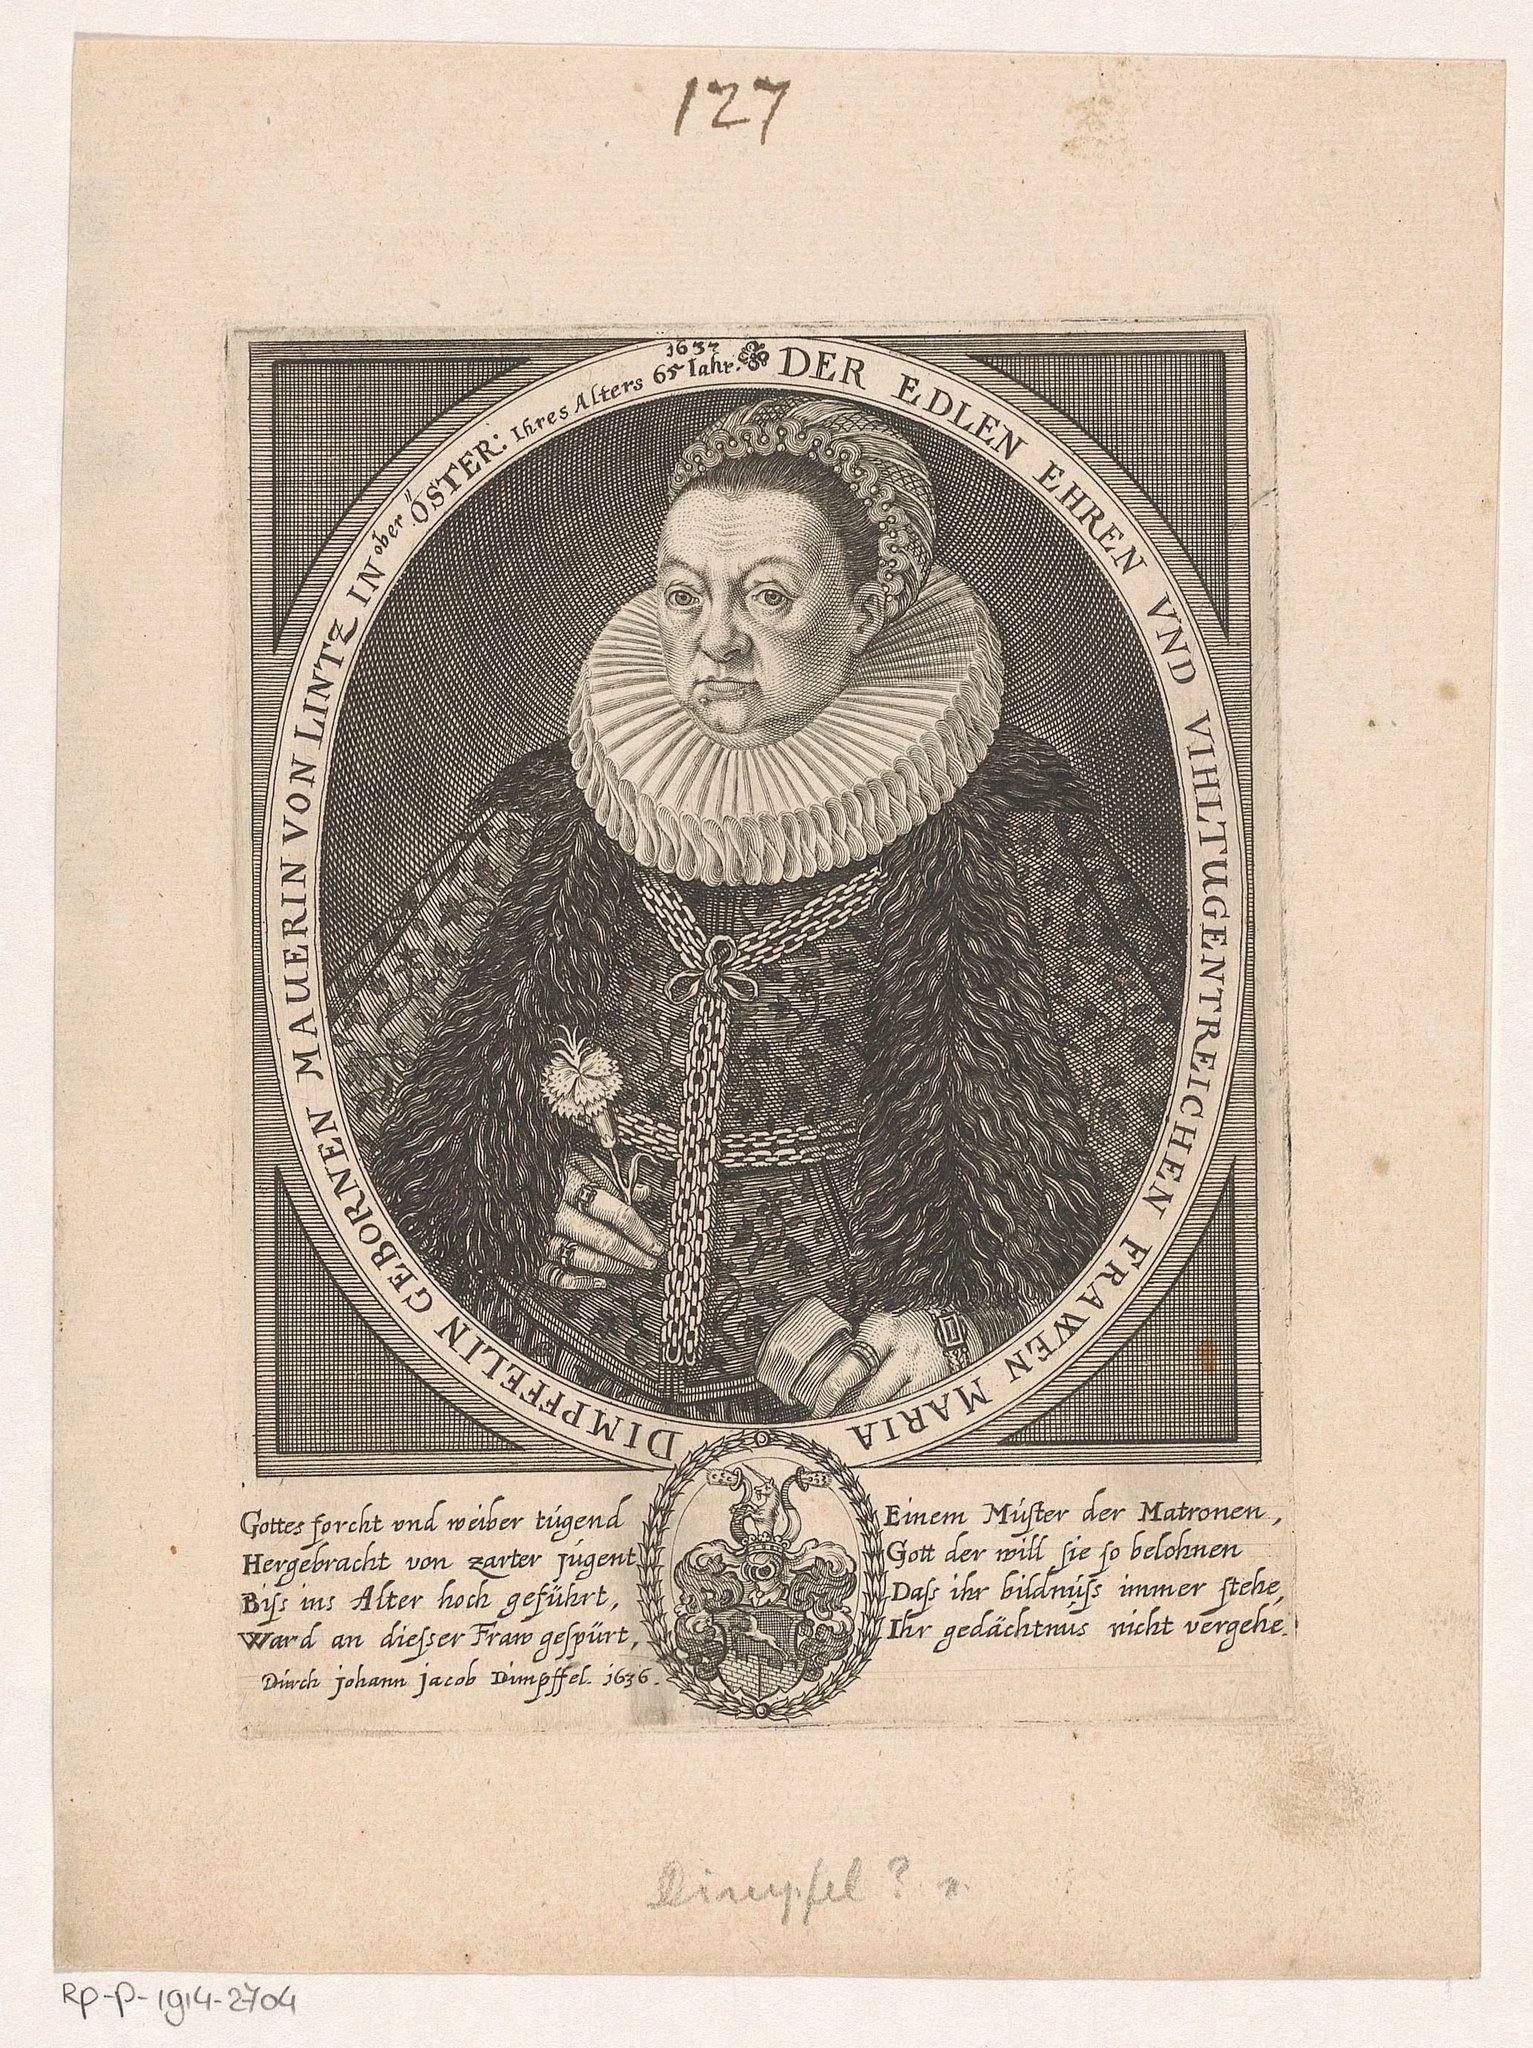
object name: print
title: Portret van Maria Dimpfel op 65-jarige leeftijd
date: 1636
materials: paper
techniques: engraving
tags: flowers, historical persons, ornaments, jewels, armorial bearing, heraldry, neck-gear: collar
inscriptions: collector's mark: Lugt 2228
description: Datum van overlijden (1637) is later toegevoegd boven de leeftijd van de geportretteerde.